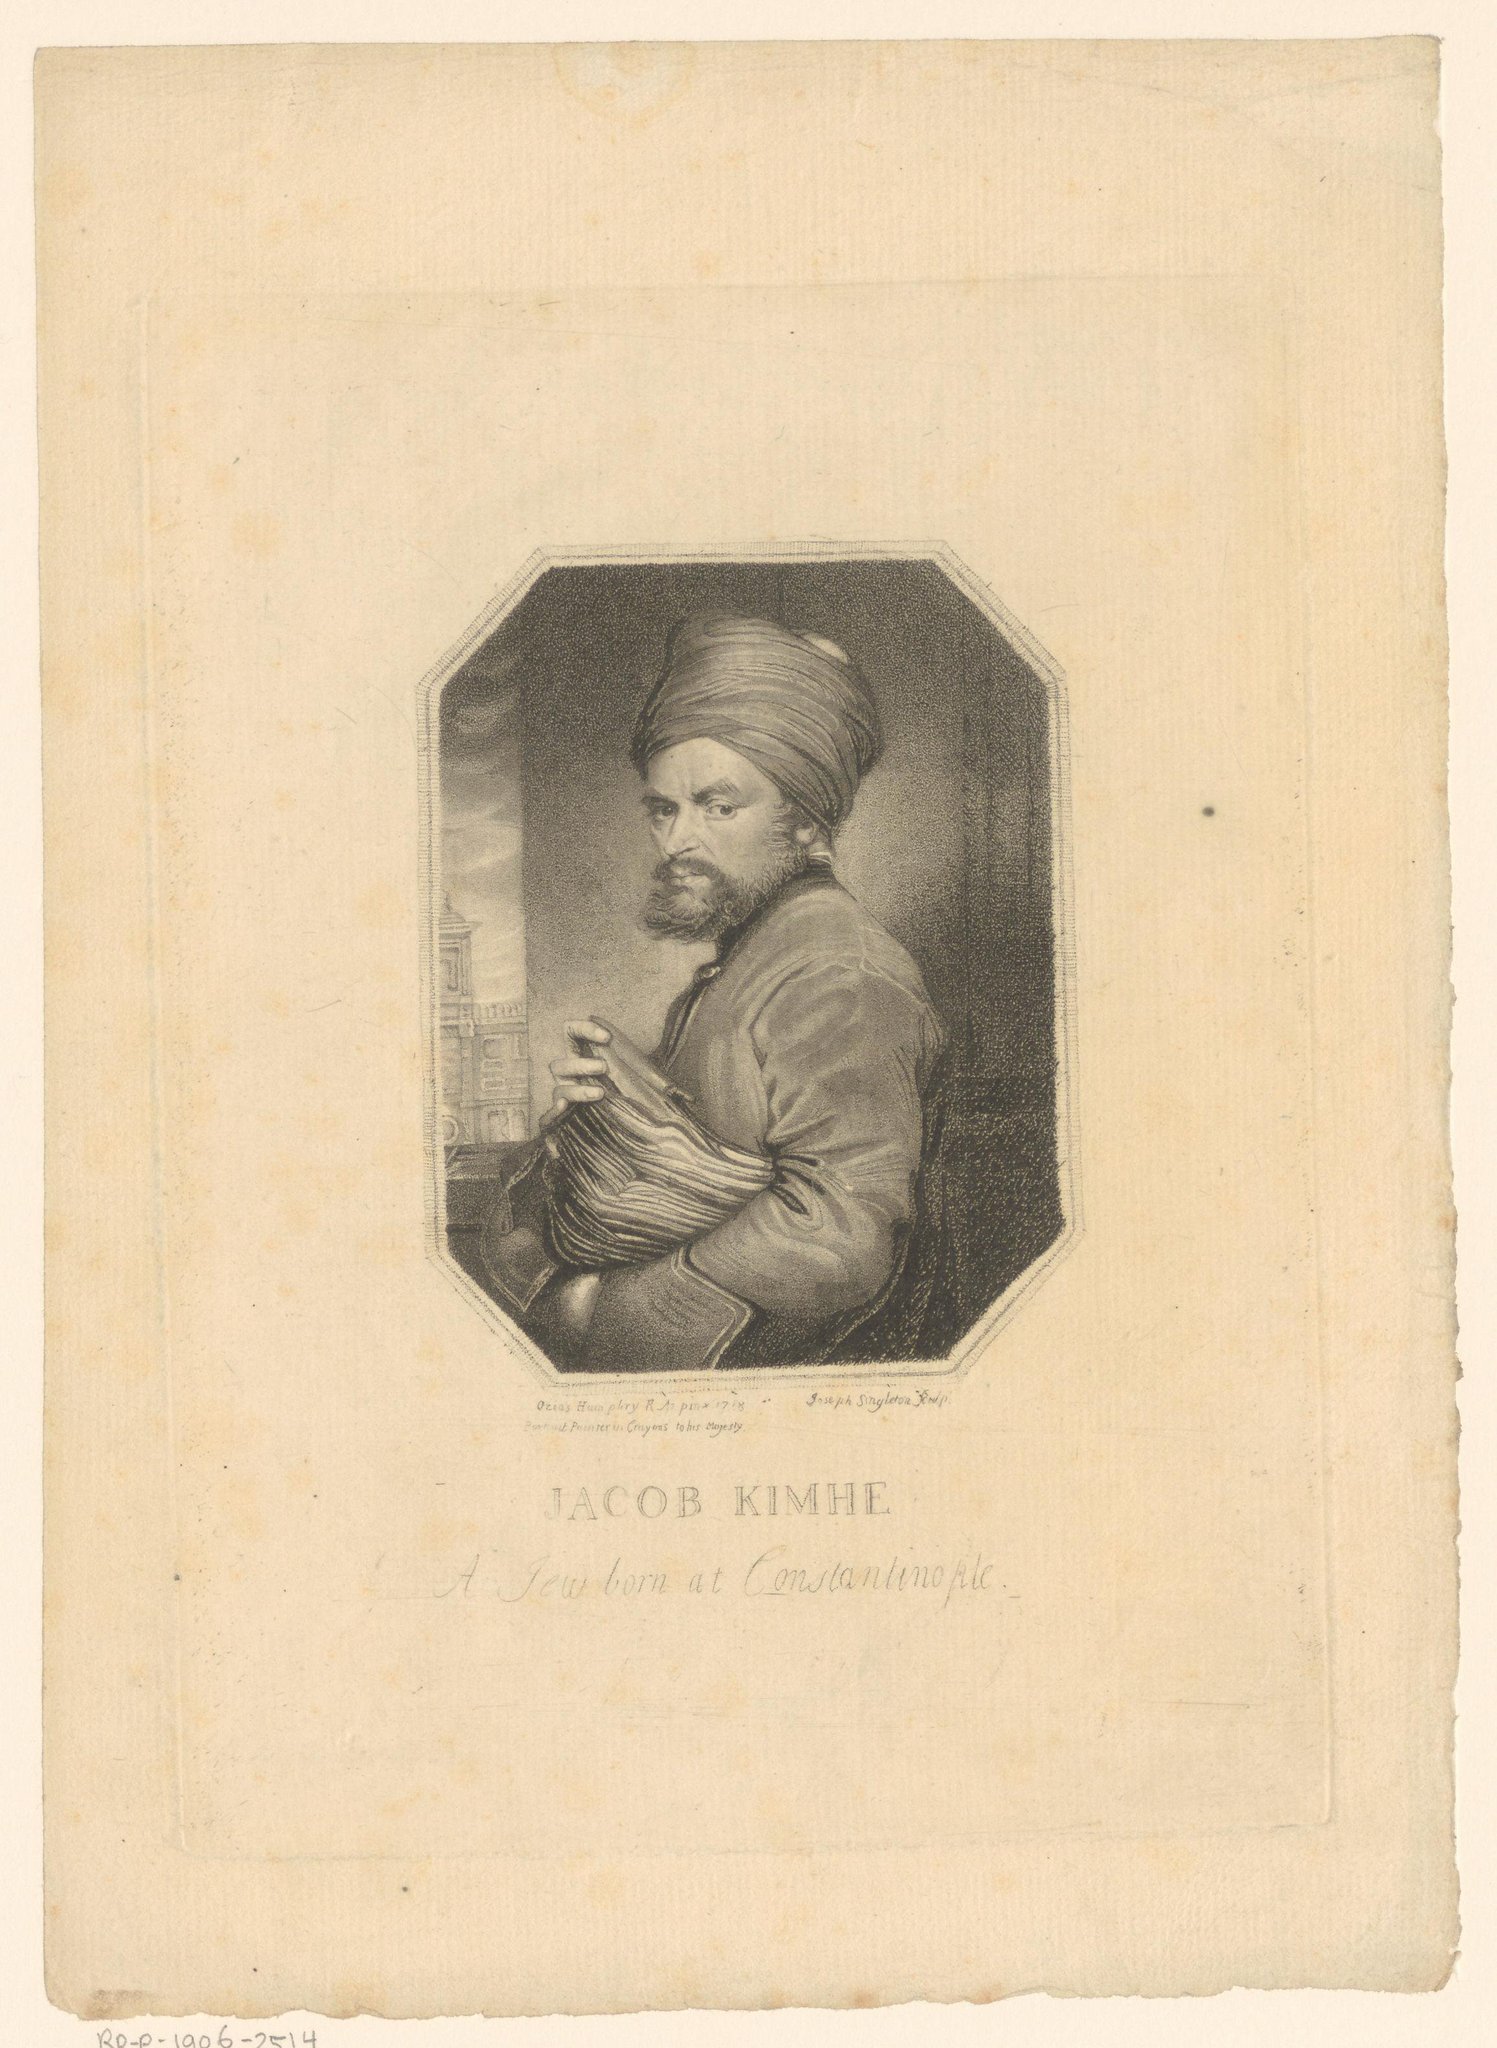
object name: print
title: Portret van Jacob Kimhi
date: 1788-1790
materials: paper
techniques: engraving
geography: great britain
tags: historical persons, merchant, salesman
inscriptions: collector's mark: Lugt 2228